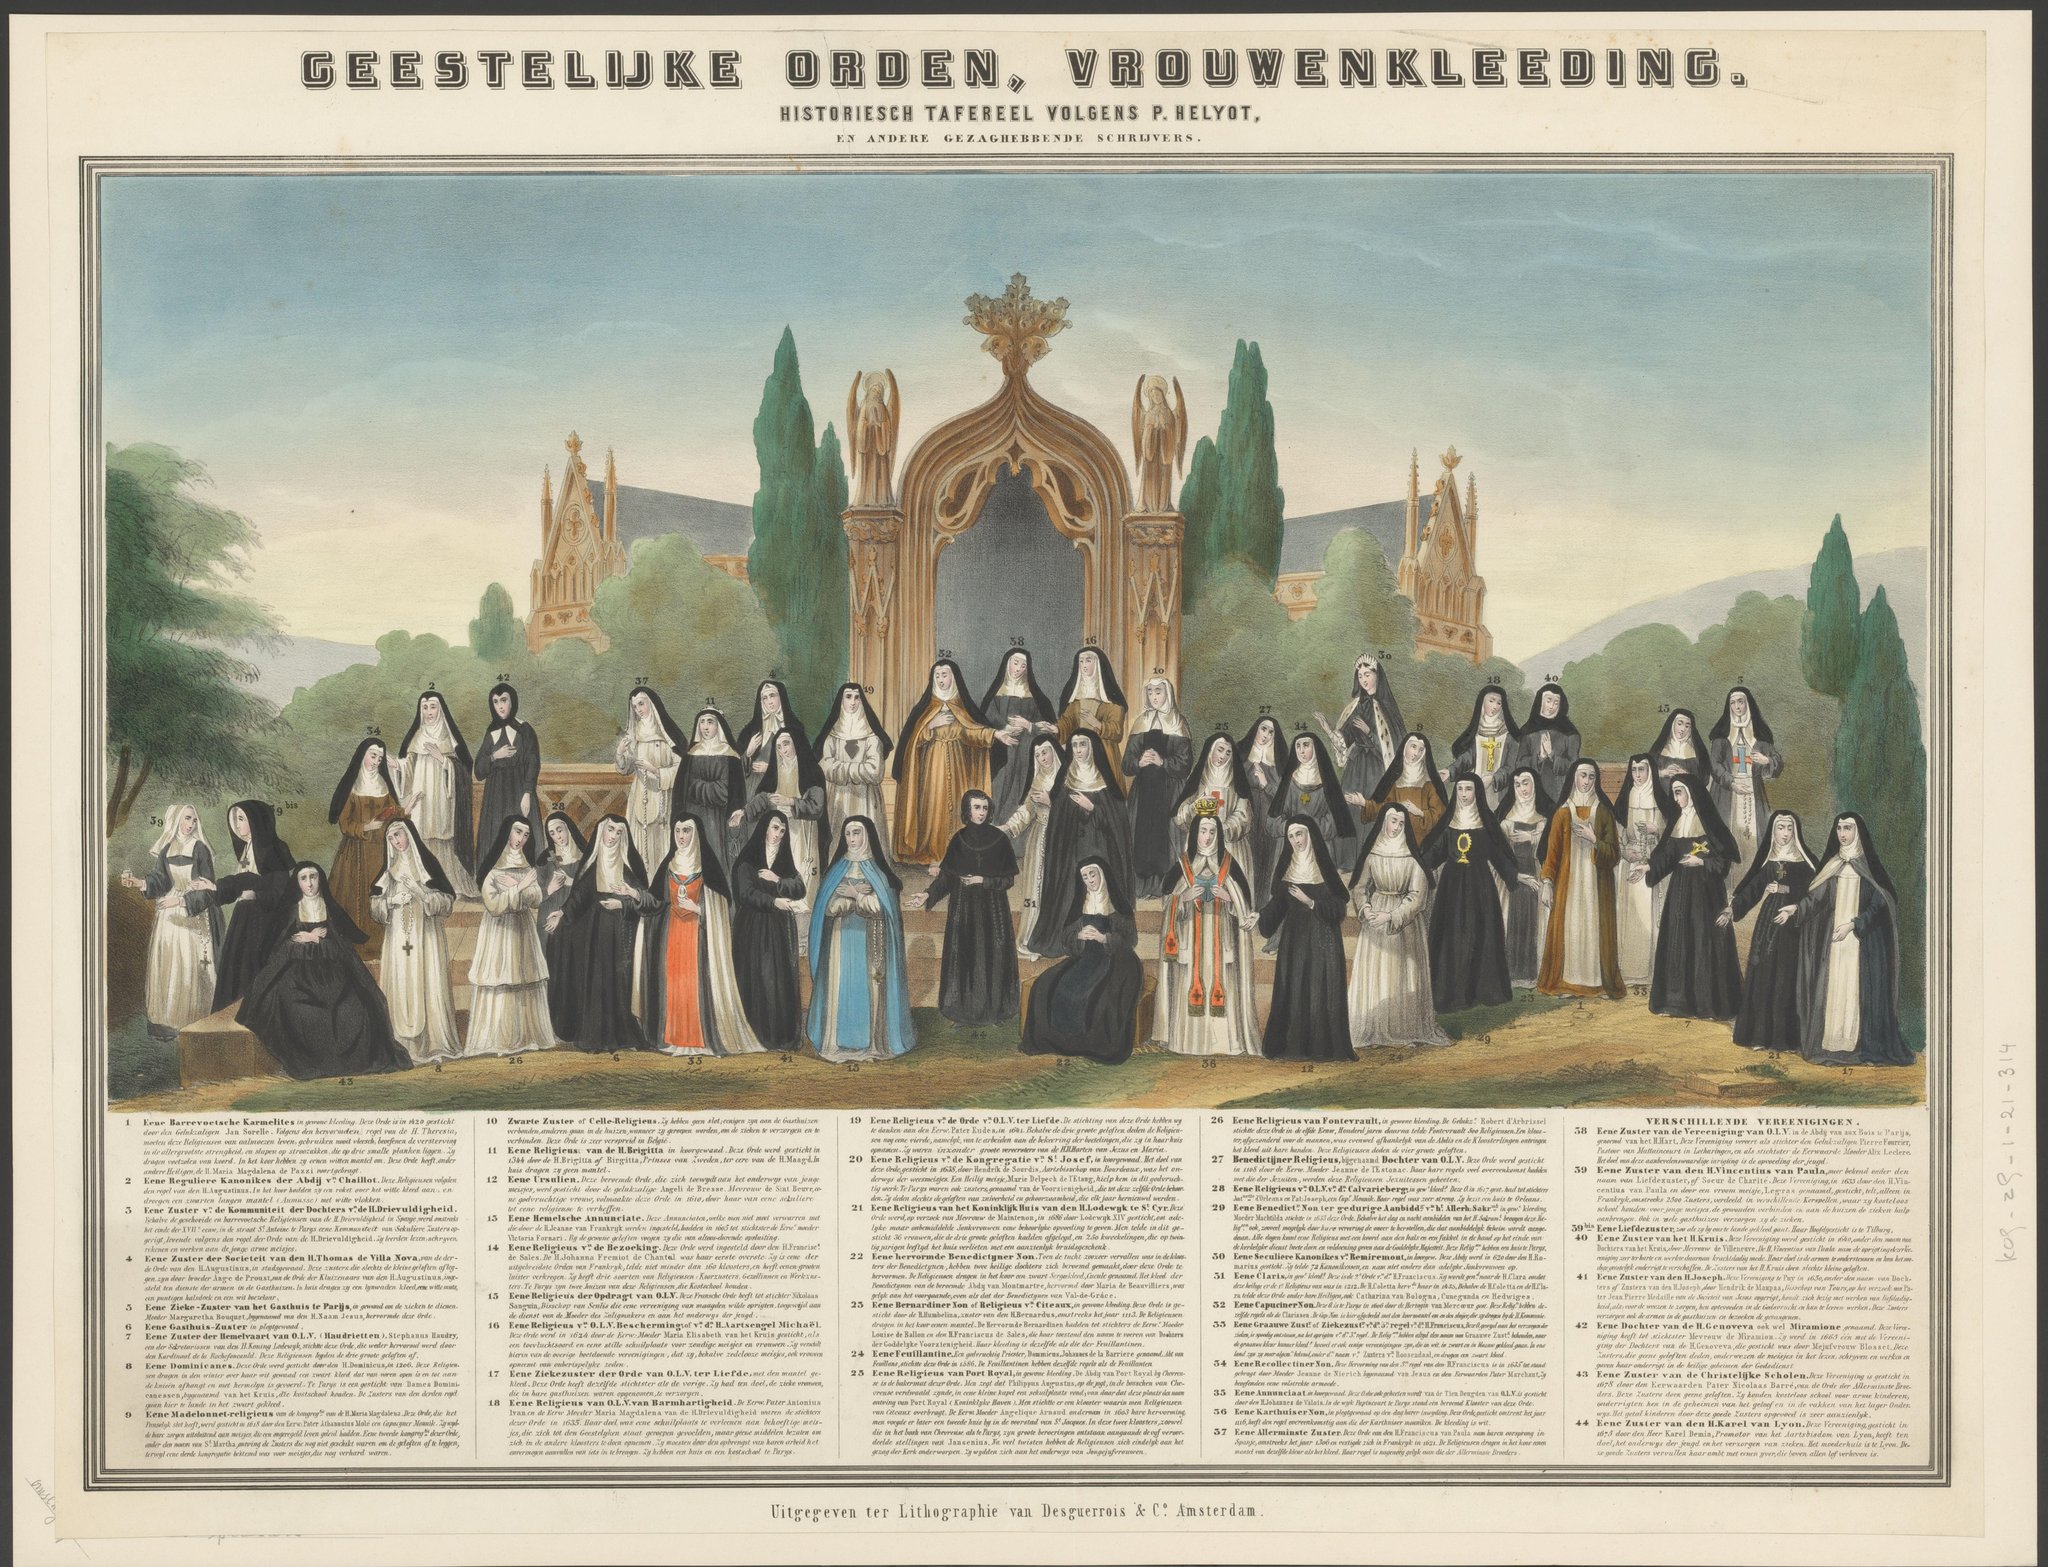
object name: print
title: Kostuums voor vrouwen uit verschillende geestelijke ordes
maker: Anonymous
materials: paper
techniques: hand coloring, lithograph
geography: amsterdam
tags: organization, functionaries and dignitaries in churches and in related institutions, clothes, costume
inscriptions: stamp, collector's mark: Lugt 1641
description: Kostuums voor vrouwen verschillende geestelijke ordes. Ieder kostuum is genummerd en onderaan staat een legenda met de benaming van de ordes en kostuum. Onderwerpsrubrieken binnen de Atlas Zeden en Gewoonten: Zeden en Gewoonten in Engeren Zin, De Kleeding, Kleederdrachten (tijdvakken), Geestelijke orden en priesters.